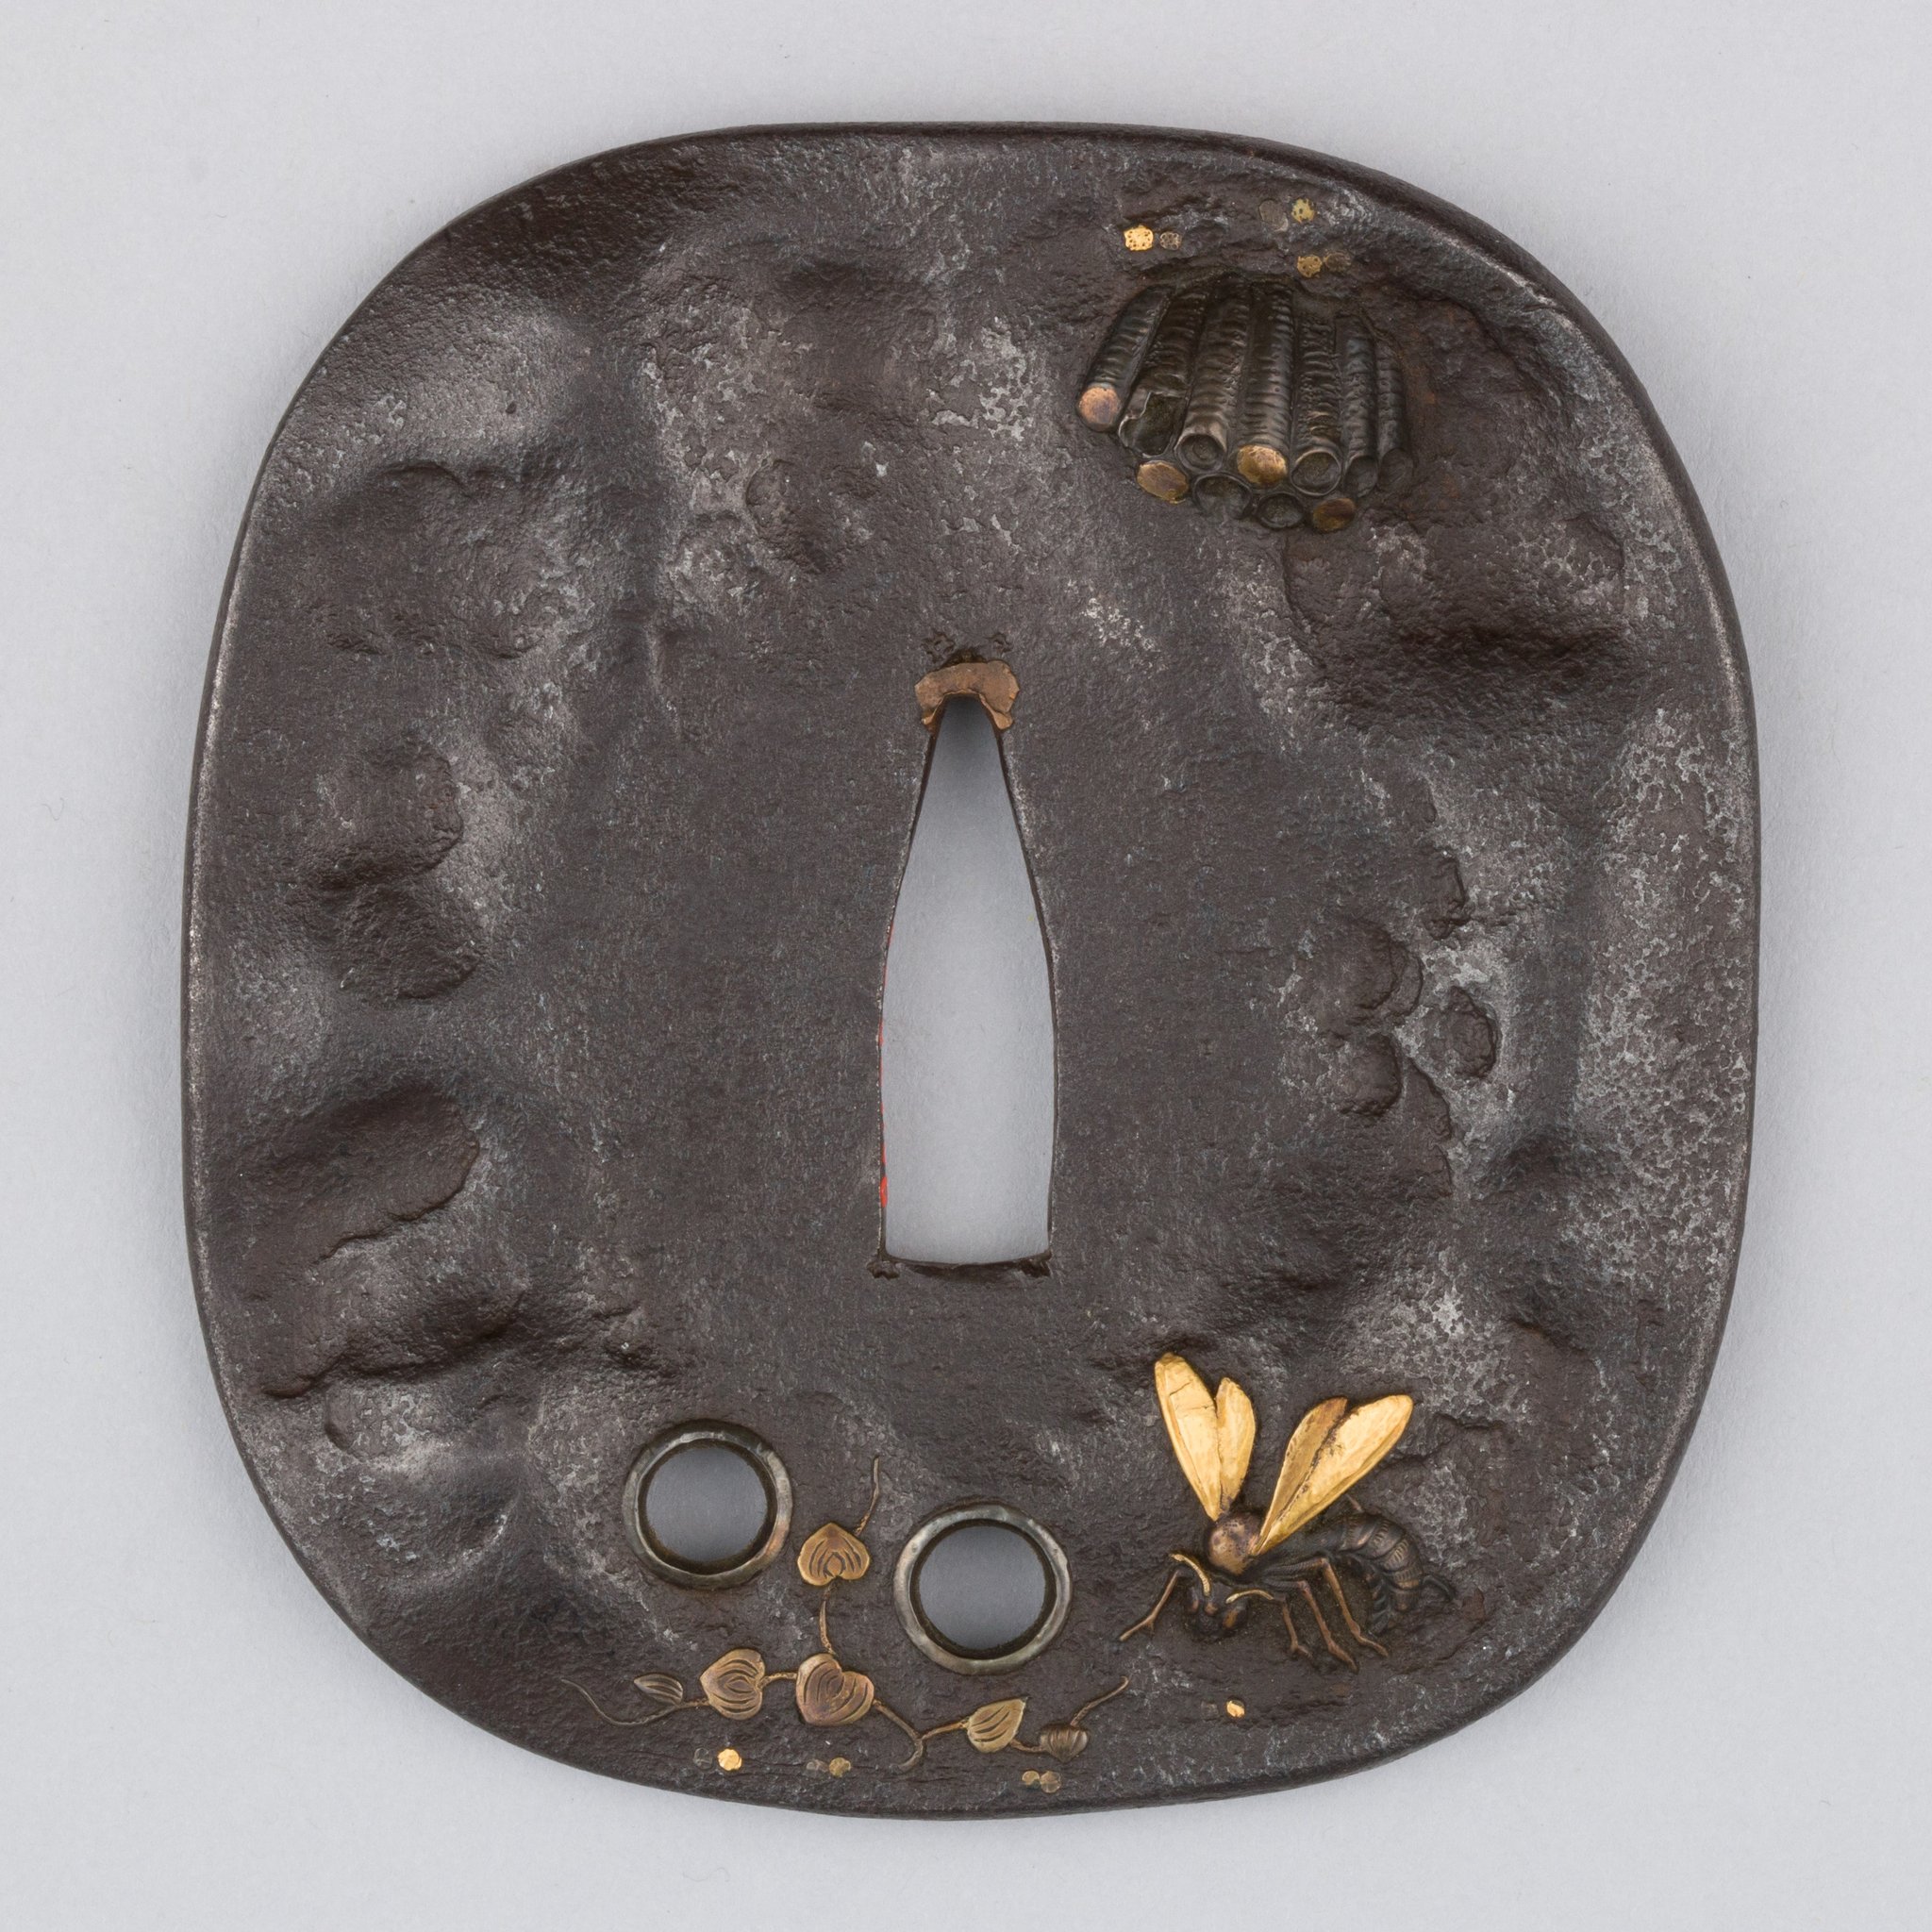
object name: sword guard tsuba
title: Sword Guard (Tsuba)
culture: japanese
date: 1739-1776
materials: brass, copper, gold, iron, silver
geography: japan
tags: insects